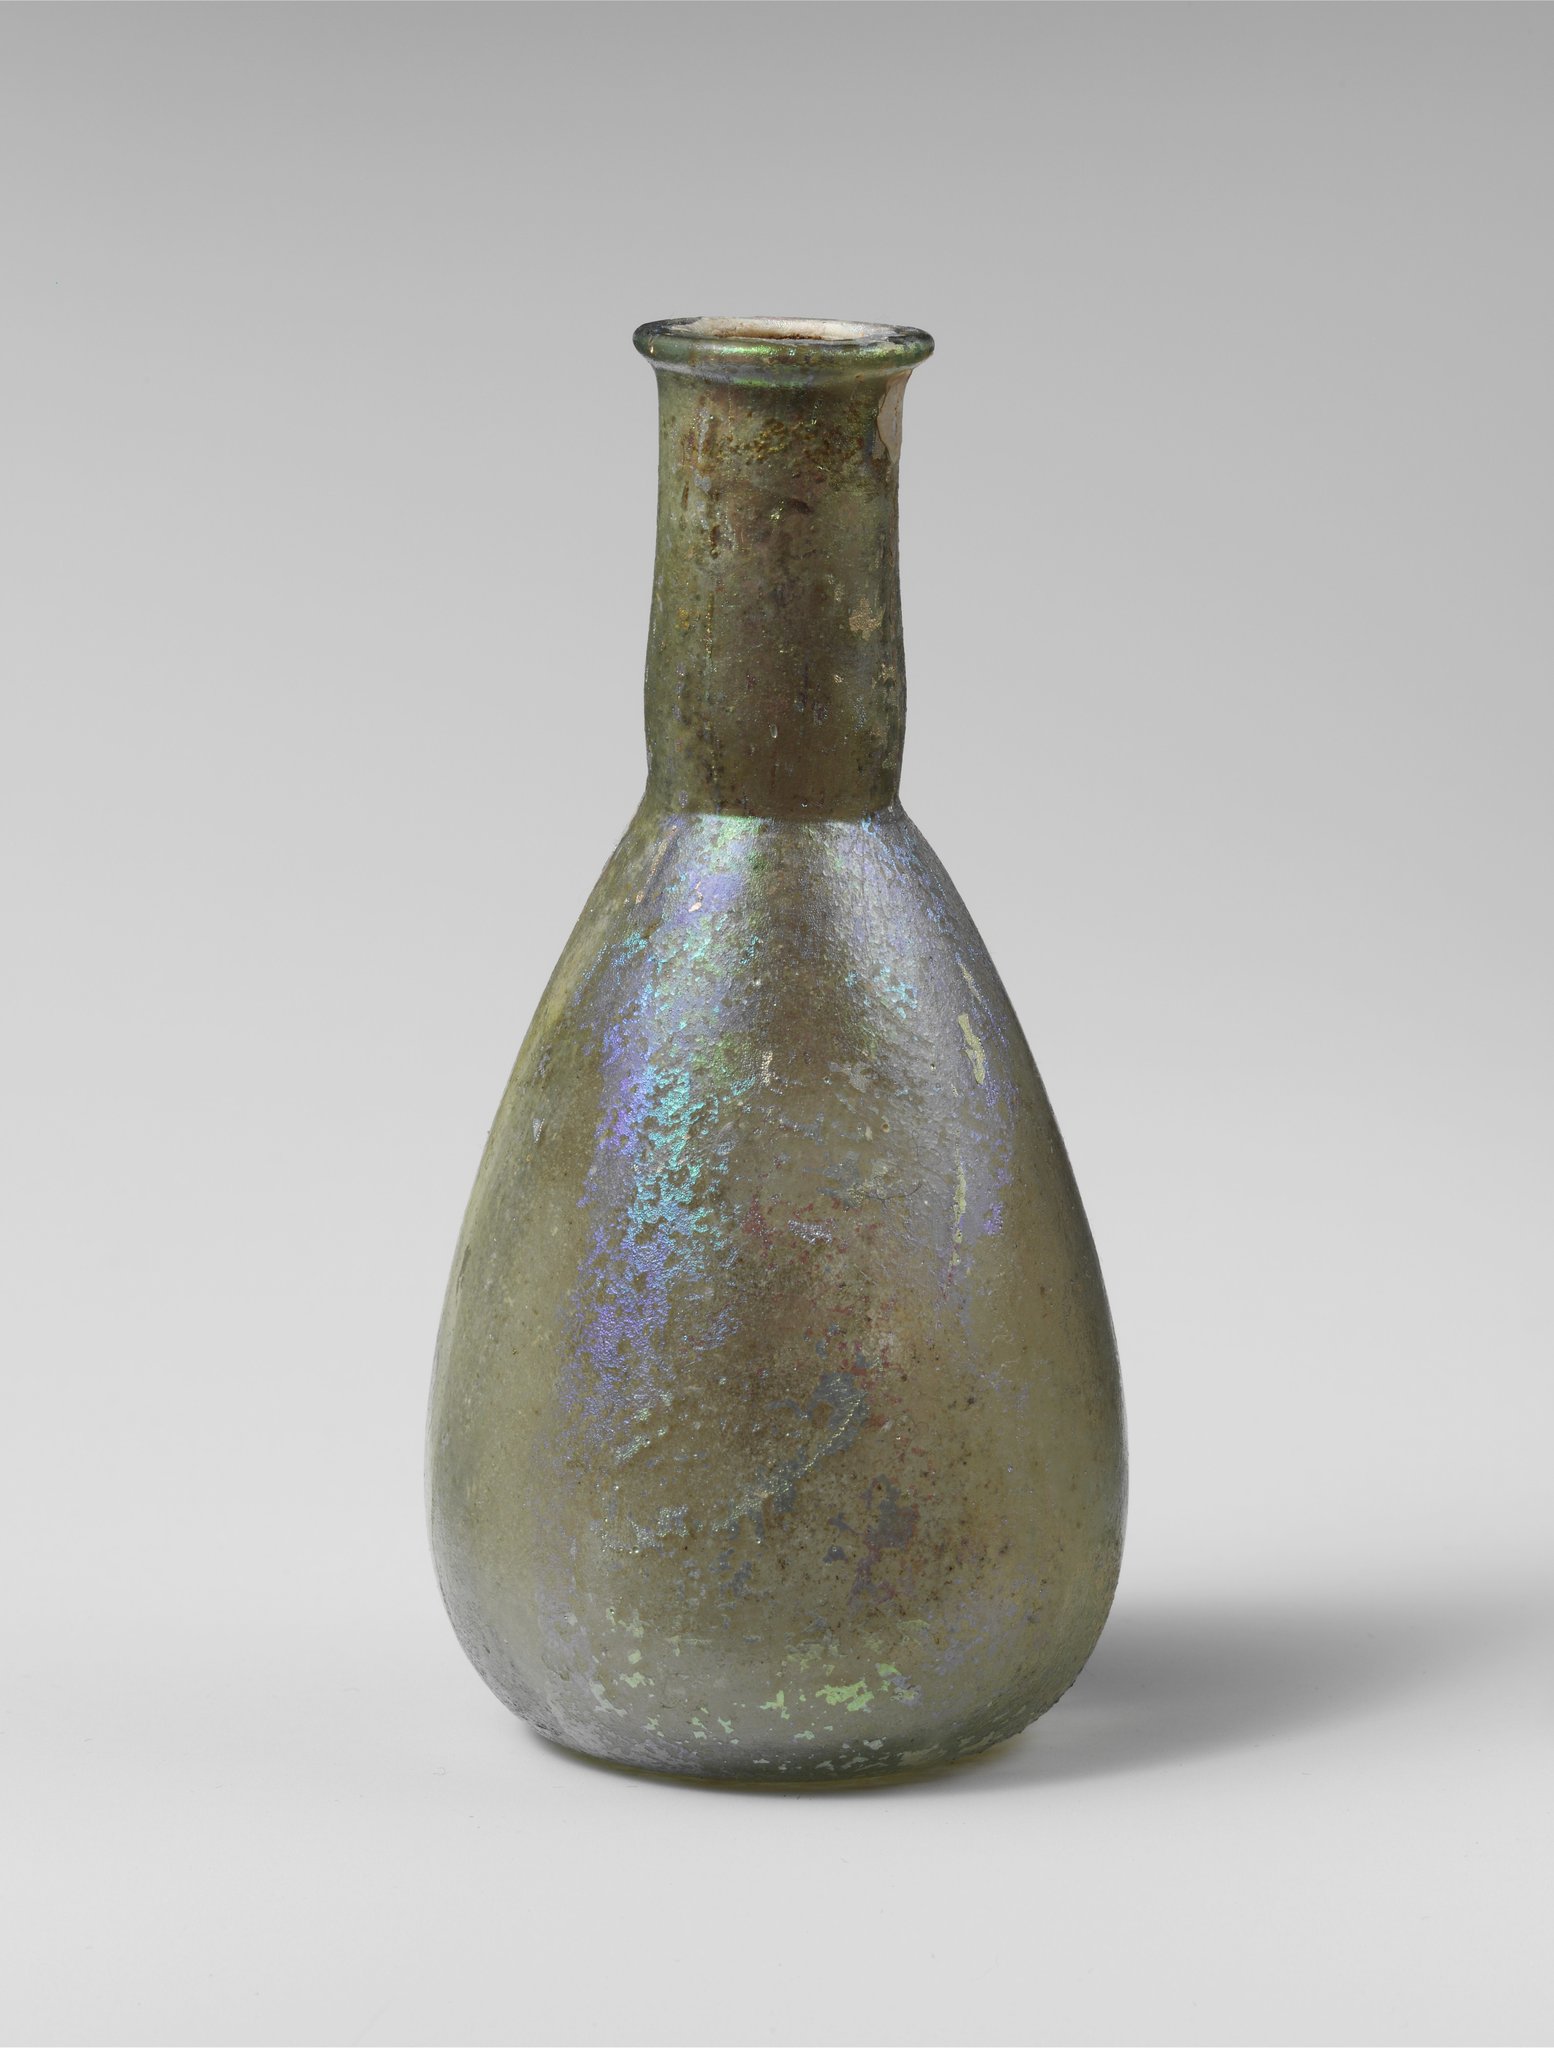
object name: perfume bottle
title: Glass perfume bottle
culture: roman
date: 1-100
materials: glass